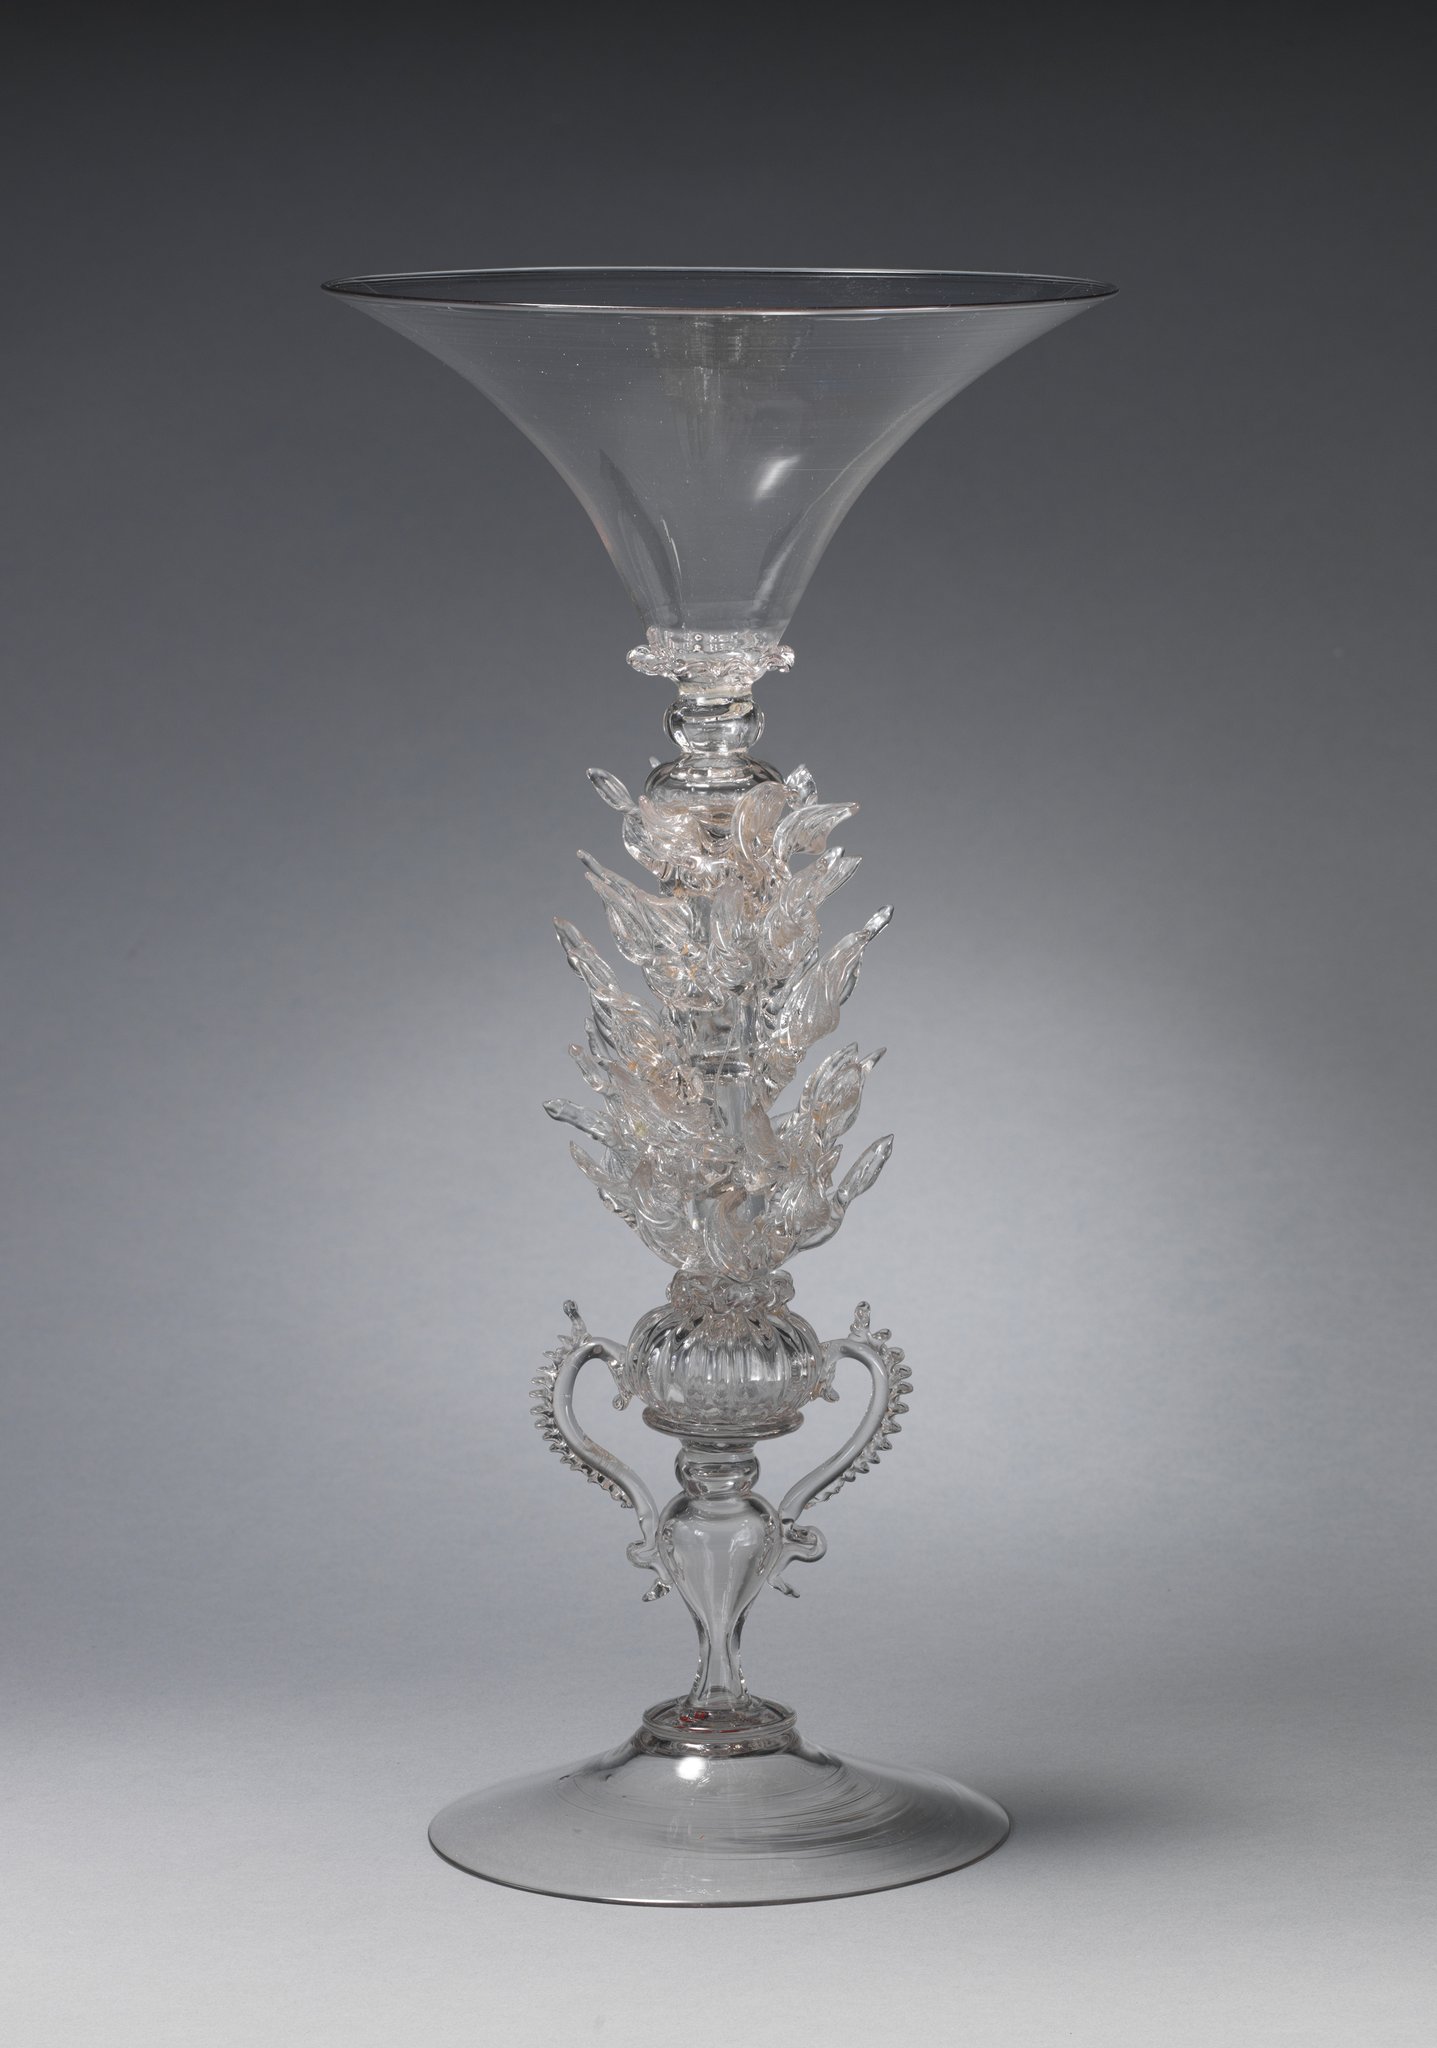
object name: goblet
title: Goblet with decorative stem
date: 1601-1800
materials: glass